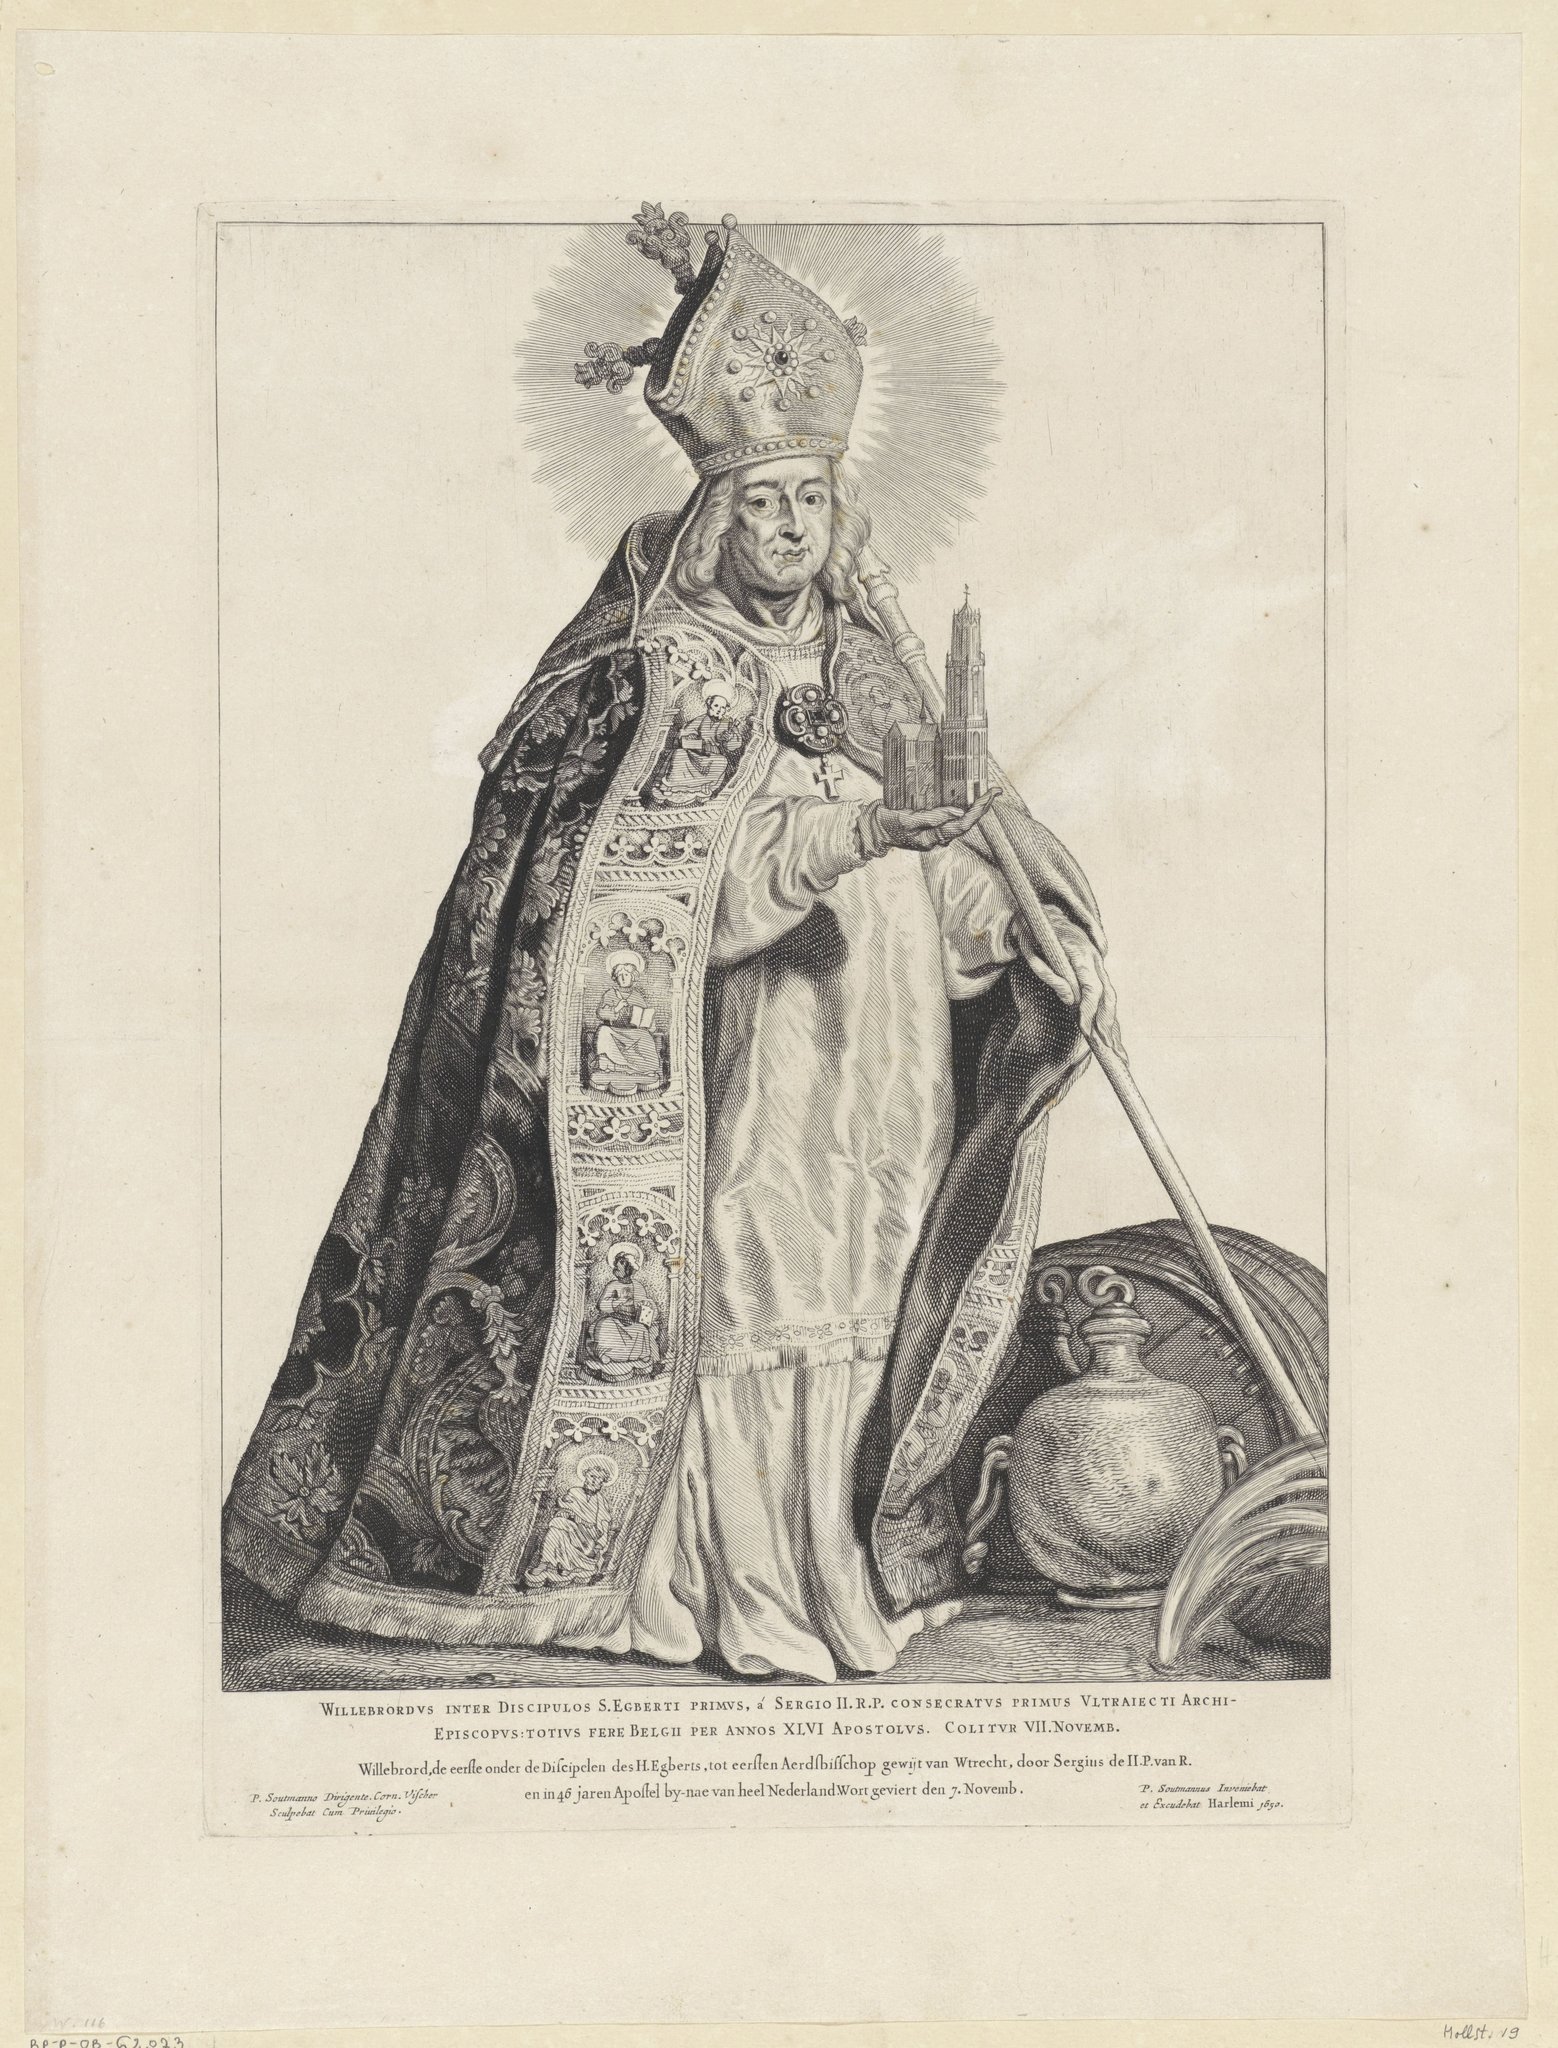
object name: print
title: H. Willibrord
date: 1650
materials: paper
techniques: engraving, etching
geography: haarlem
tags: church (exterior), the 'apostle of frisia' and archbishop of utrecht, willibrord (of echternach); possible attributes: cask (barrel), well (fountain), child (on a book), model of church, stone bottles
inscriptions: collector's mark: Lugt 2228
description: Deze prent maakt deel uit van de serie: Iesv Christo, Fideli Militantis Ecclesiae Imperatori, Liberali Eivsdem, Trivmphantis, Remvneratori, hos In Foederato Belgio Militiae Svae Legatos, Sanctissimos Sacri Belli Dvces, Patriae Apostolos, Et Decora Lvmina, Cvm Dvabvs Heroinis, Militans In Iisdem Provinciis Ecclesia. Haarlem: Pieter Claesz. Soutman, 1650.